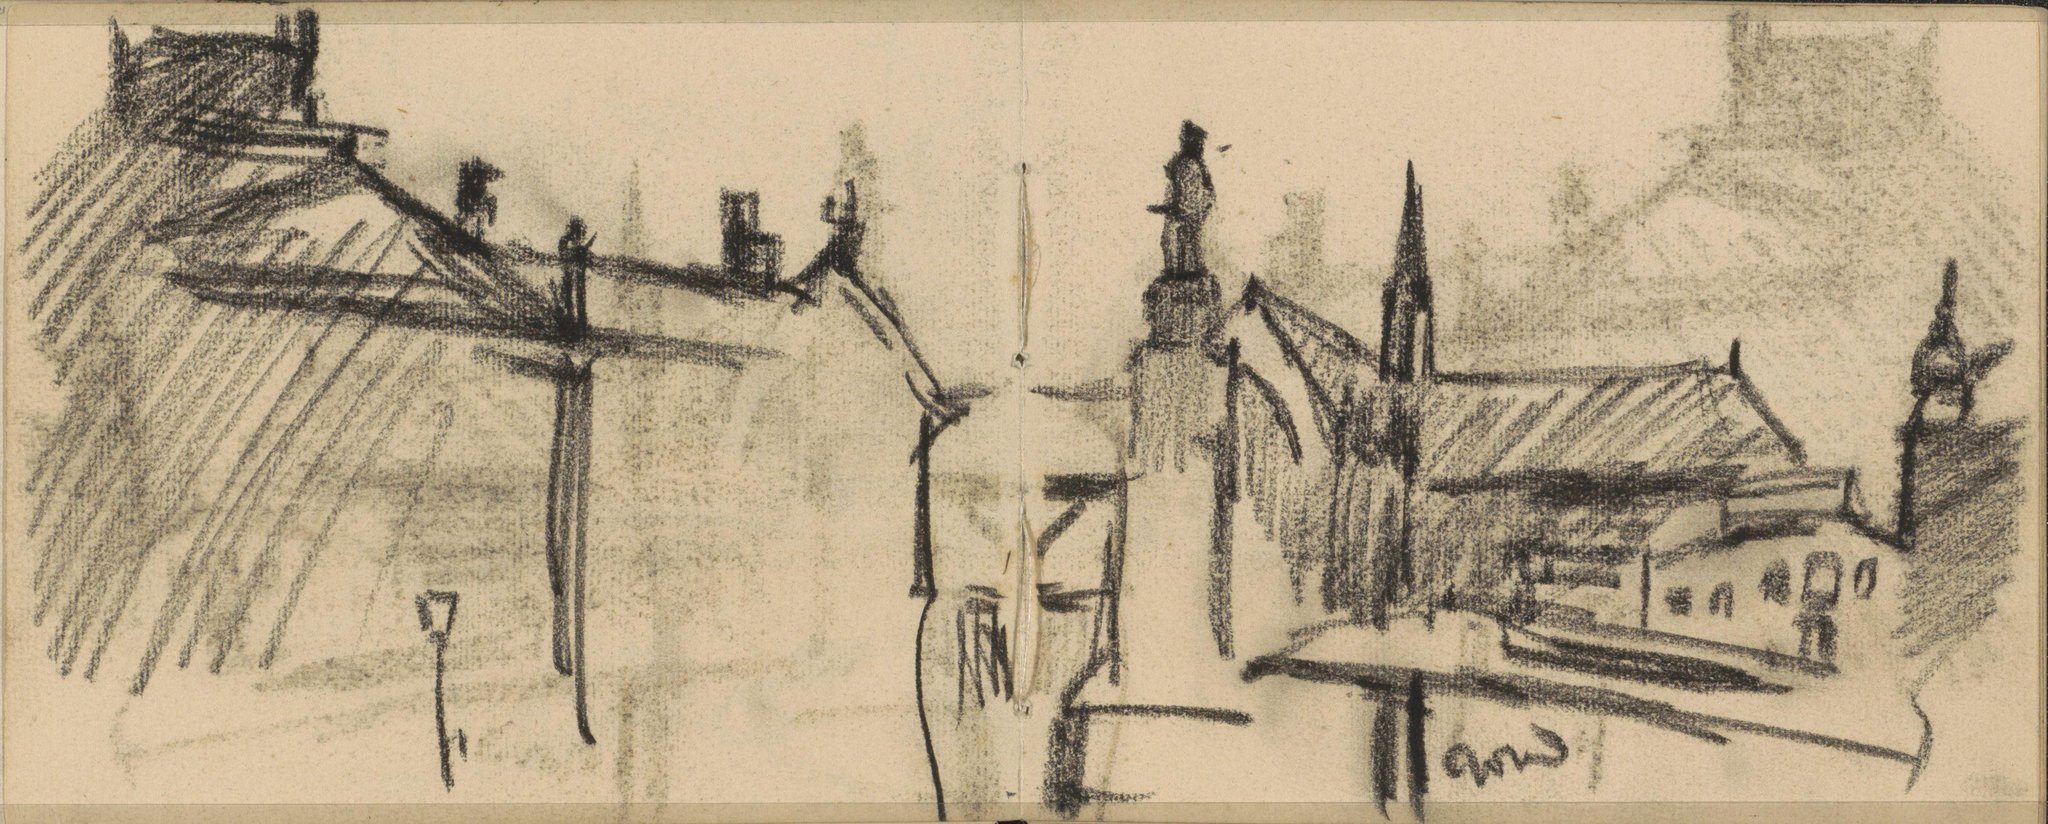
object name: sketchbook leaf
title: Gezicht op de Dam te Amsterdam met het Koninklijk Paleis, de Nieuwe Kerk en Naatje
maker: george hendrik breitner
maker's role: draughtsman, painter, print maker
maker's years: 1857-1923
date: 1893-1912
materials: chalk, paper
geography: amsterdam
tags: square, place, circus, etc., church (exterior), royal palace of amsterdam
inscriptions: kleurnotitie, handgeschreven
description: Pagina 23 en pagina 24 uit een schetsboek met 32 bladen.